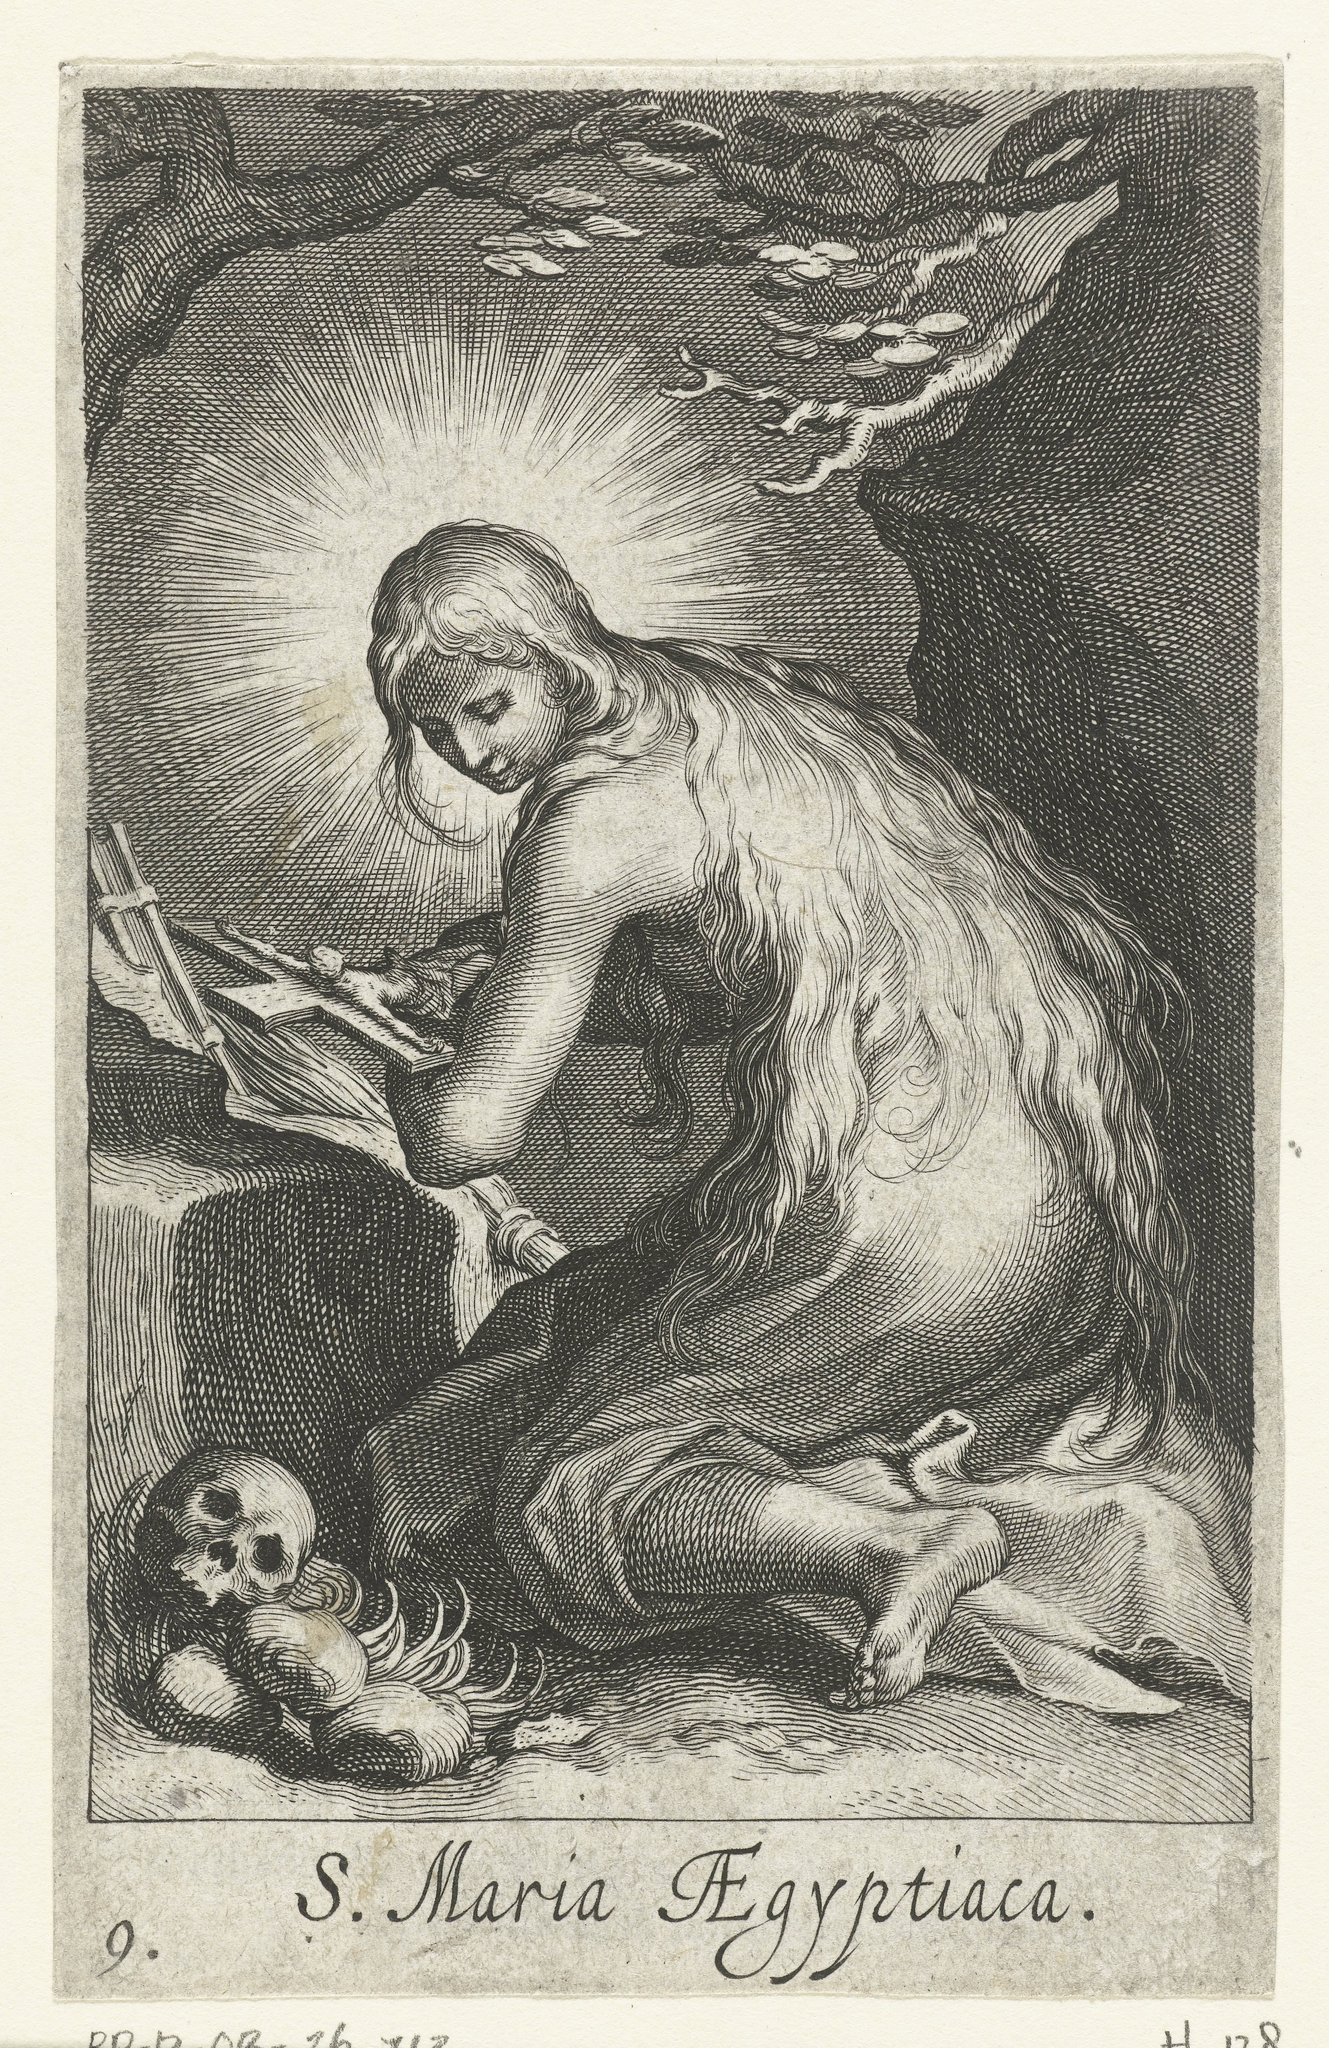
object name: book illustration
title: Heilige Maria van Egypte als kluizenares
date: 1590-1612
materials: paper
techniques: engraving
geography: antwerp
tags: the penitent harlot mary of egypt (maria aegyptiaca); possible attributes: long hair, three loaves, anchorite, hermit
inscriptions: collector's mark: Lugt 2228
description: Prent uit: Sacra Eremus Ascetriarum, Hendrik Aertssen, Antwerpen 1619. Prent uit de serie van vijfentwintig kluizenaressen in deze uitgave. In 1612 verscheen de ongebonden editie maar op basis van de gewijzigde opschriften en samenstelling van de serie kluizenaars wordt aangenomen dat de prenten van de uitgave 1619 ook in 1612 of iets daarvoor gedrukt werden. De serie kluizenaressen bleef vrijwel ongewijzigd in de ongebonden uitgave van 1612, dit compliceert de datering van de losse bladen in de collectie van het RMA, zie Roethlisberger 1993, p. 171-175. Door de aanwezigheid van Franse tekst op het verso kunnen we vaststellen dat dit blad afkomstig is uit de Antwerpse uitgave van 1619.